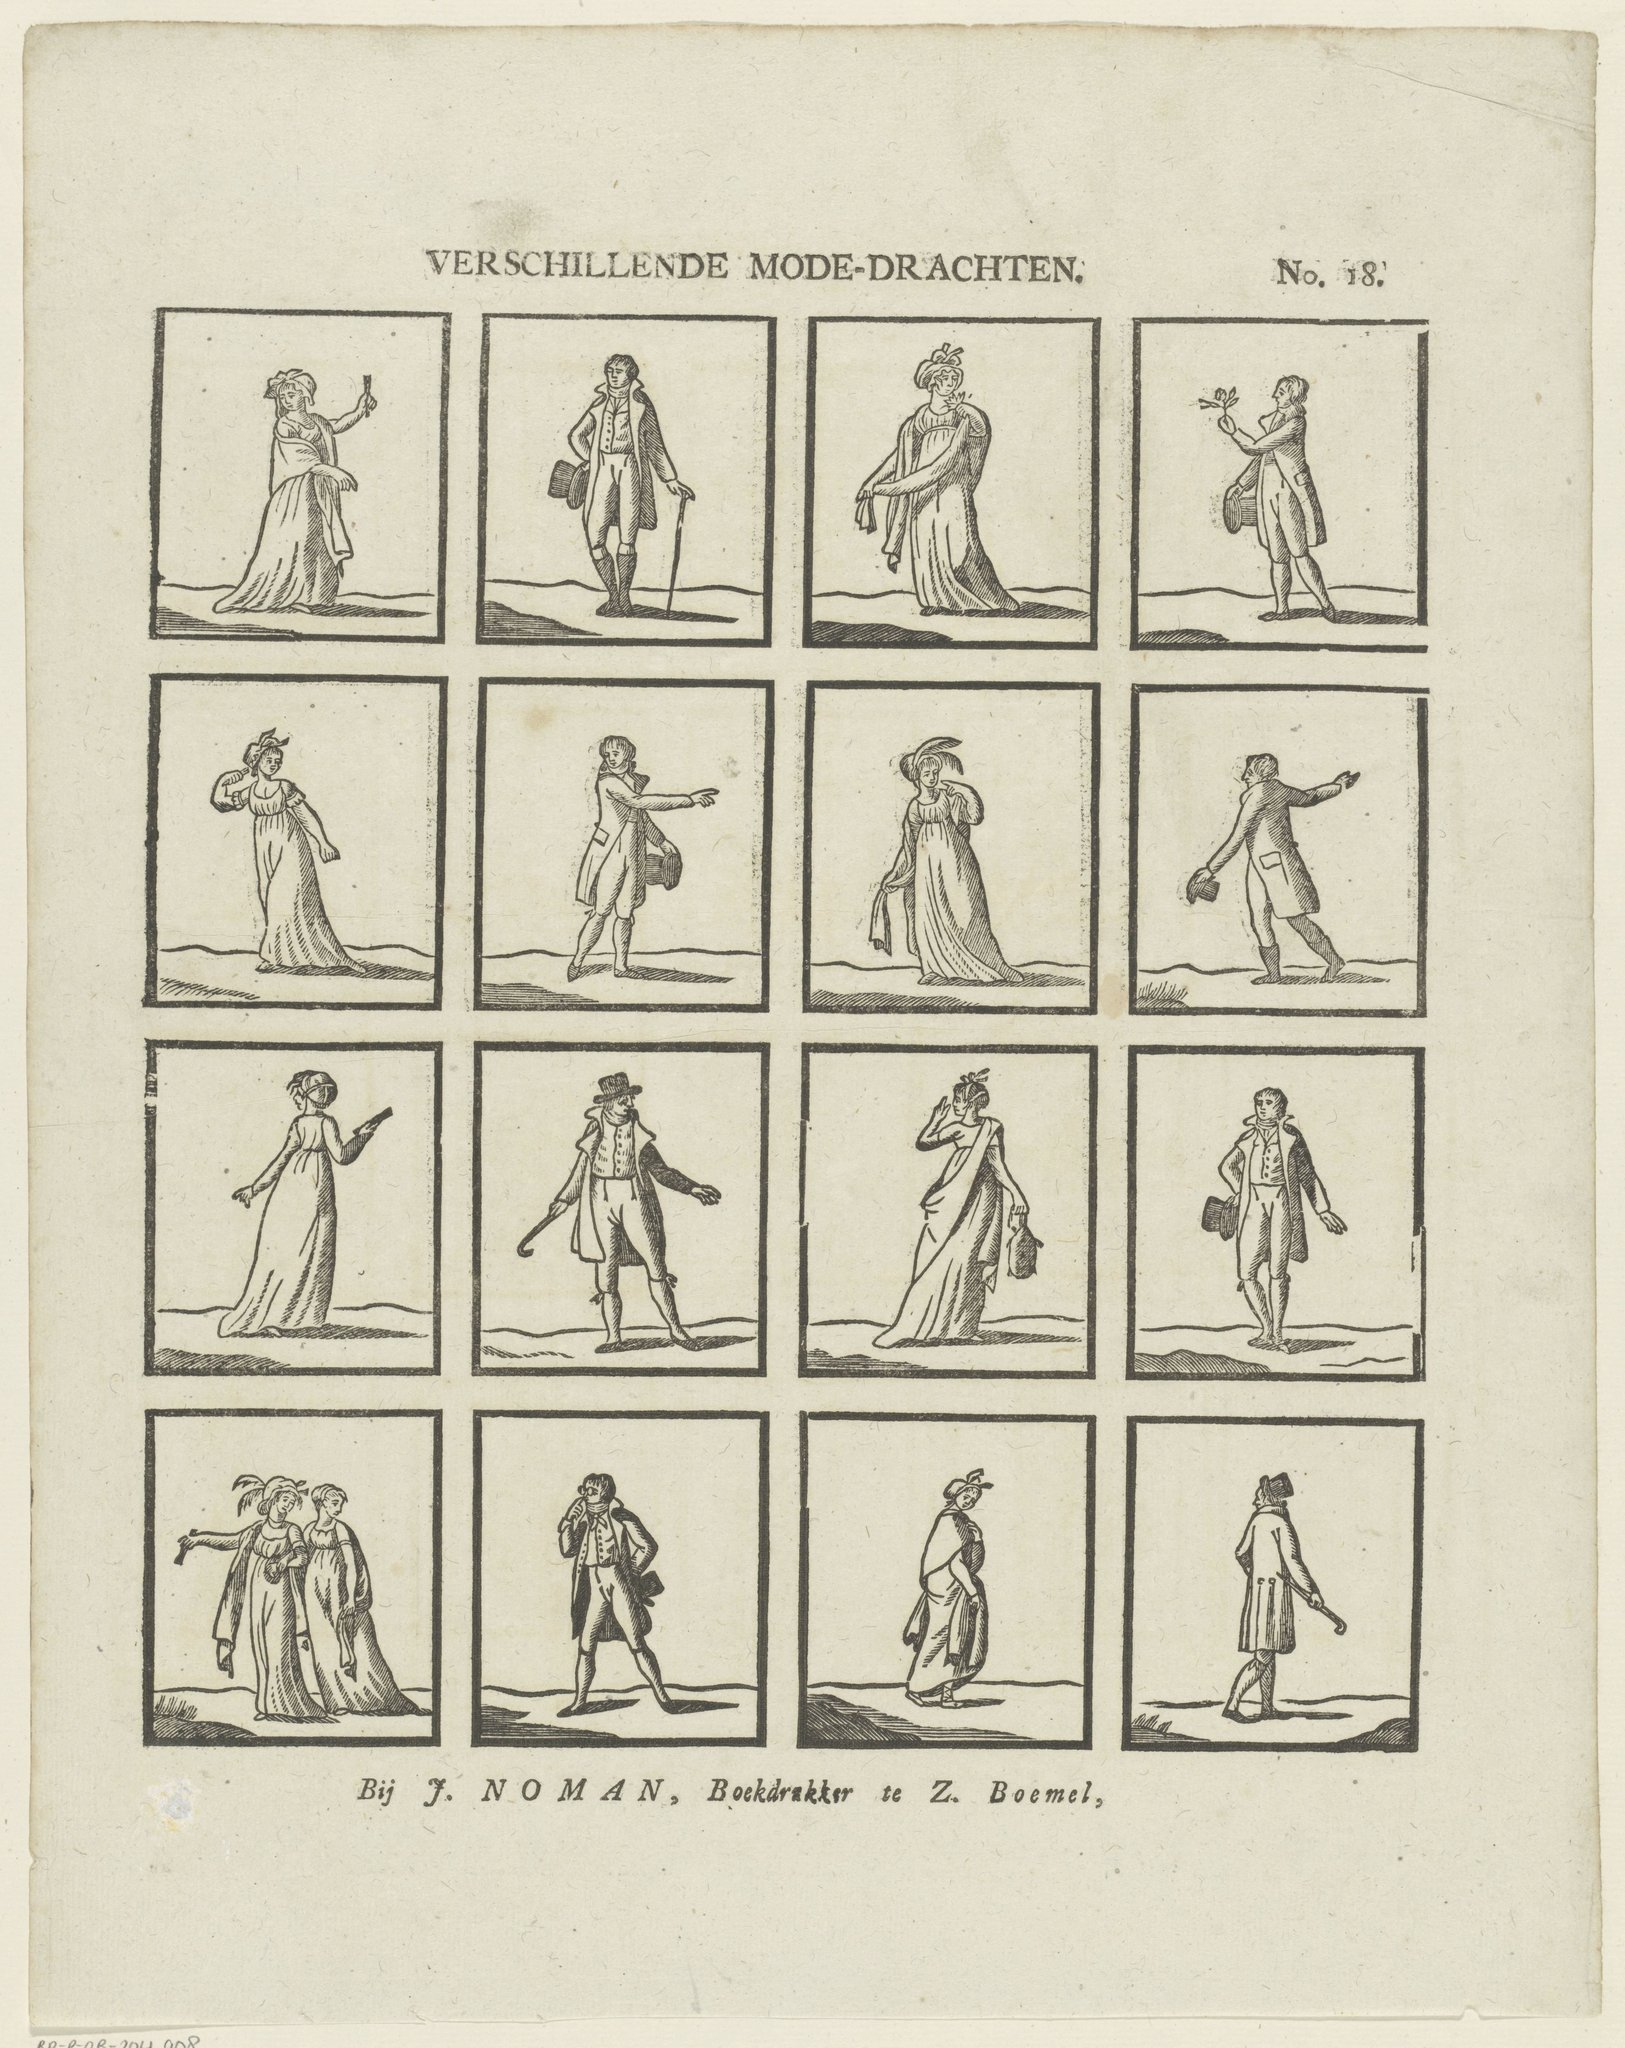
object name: print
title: Verschillende mode-drachten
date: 1806-1830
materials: paper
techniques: letterpress printing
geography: zaltbommel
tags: fashion, clothing, fashion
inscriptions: collector's mark: Lugt 2760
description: Blad met 16 voorstellingen van figuren in modieuze kleding. Genummerd rechtsboven: No. 18.